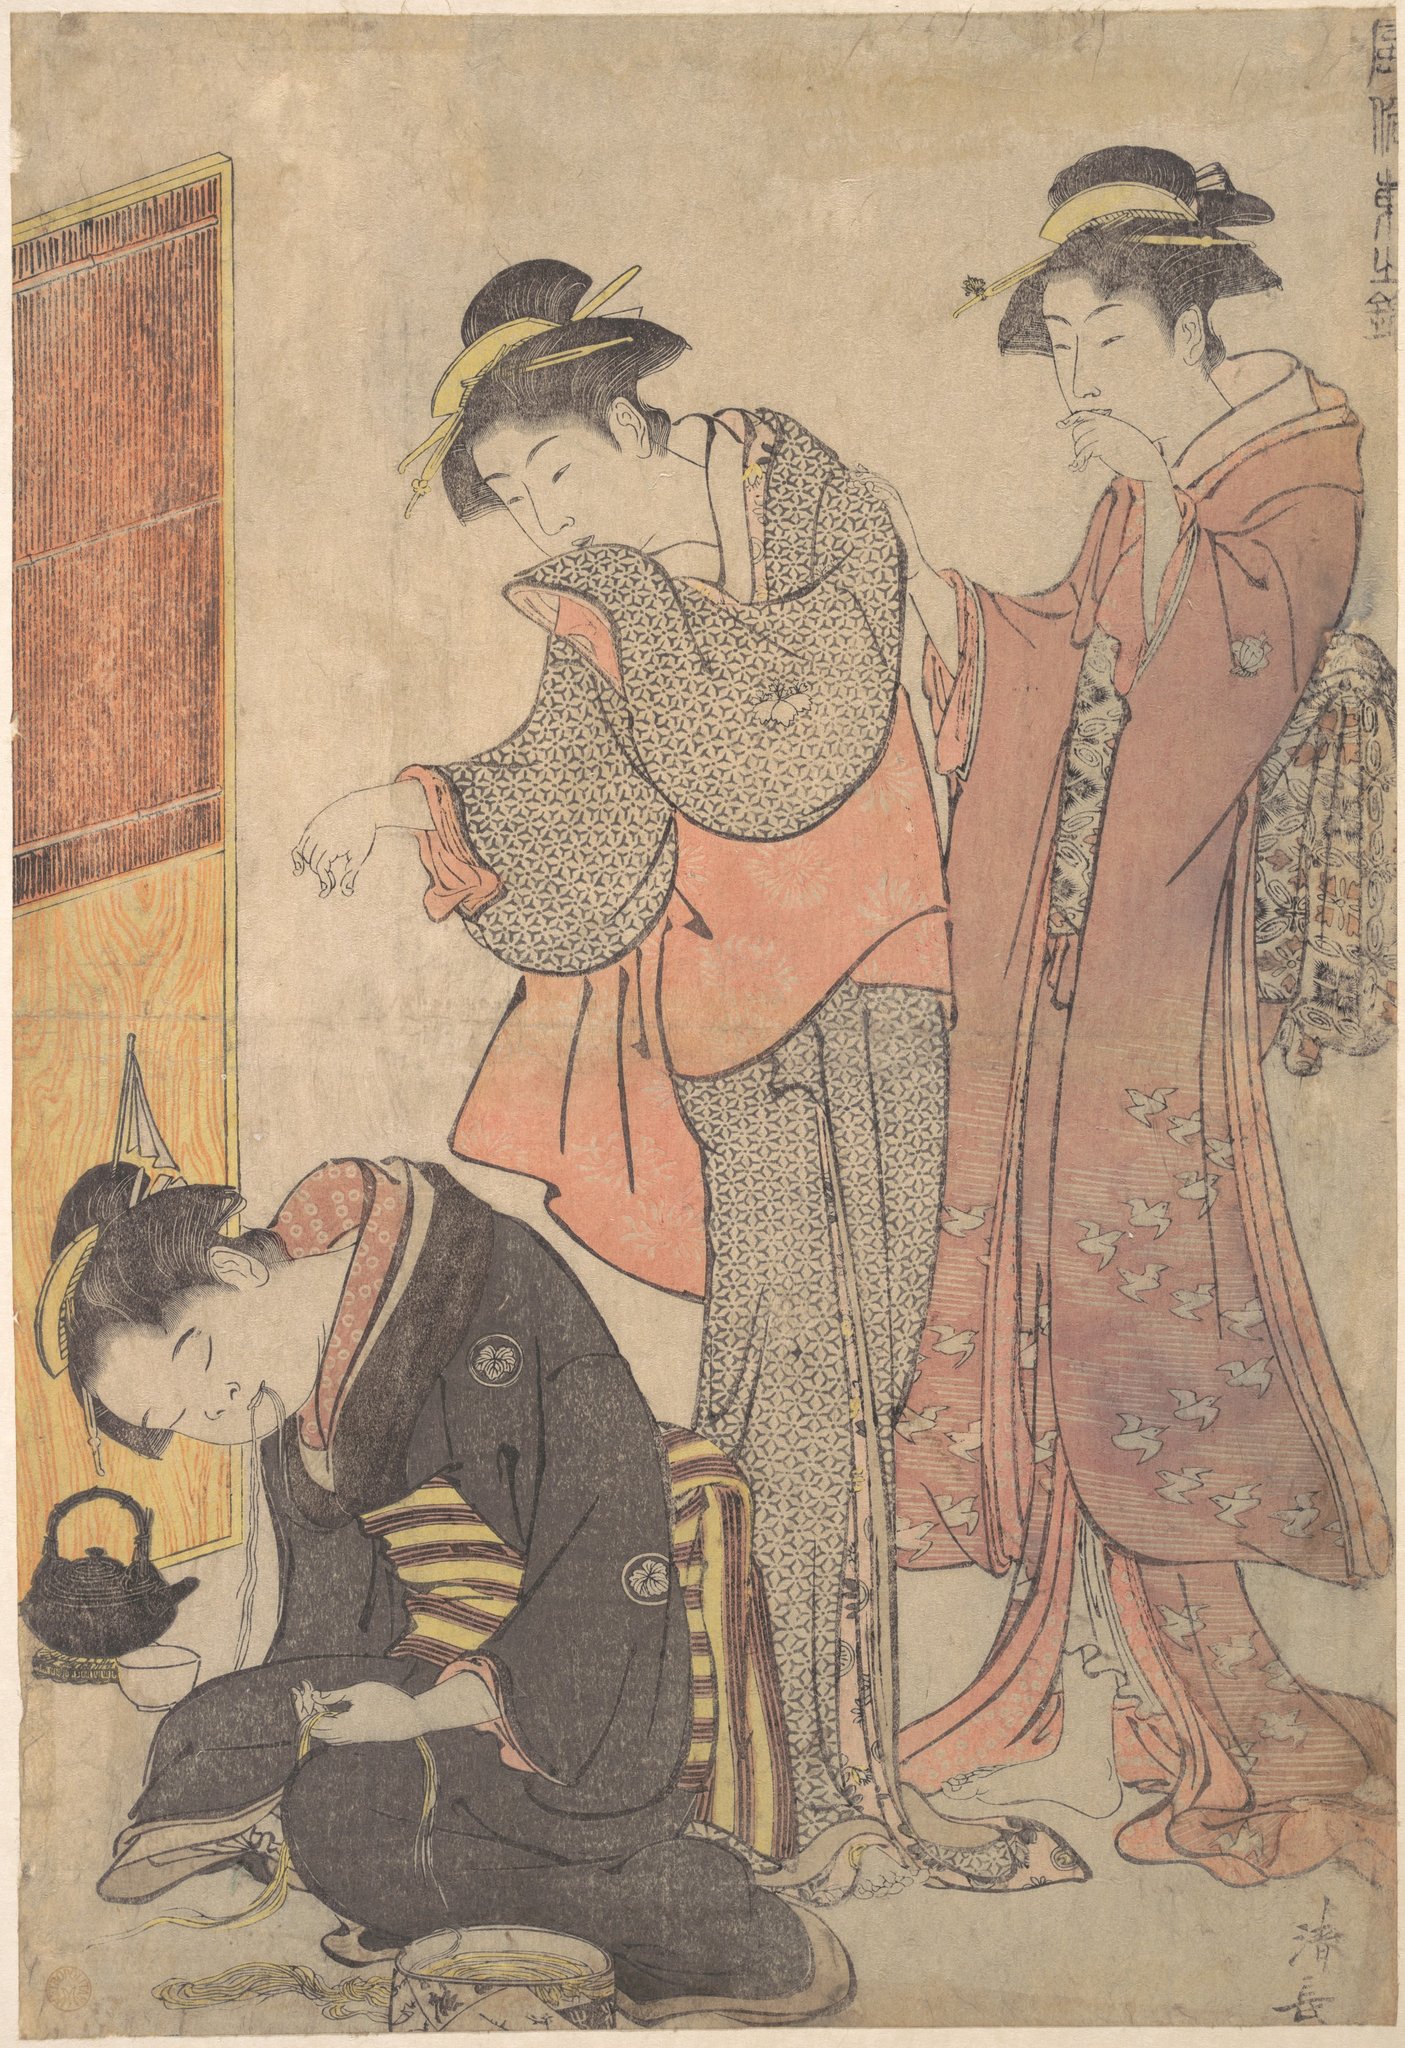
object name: print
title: A Practical Joke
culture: japanese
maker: torii kiyonaga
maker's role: artist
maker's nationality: japanese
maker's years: 1752-1815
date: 1782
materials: ink, paper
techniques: woodblock print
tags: women